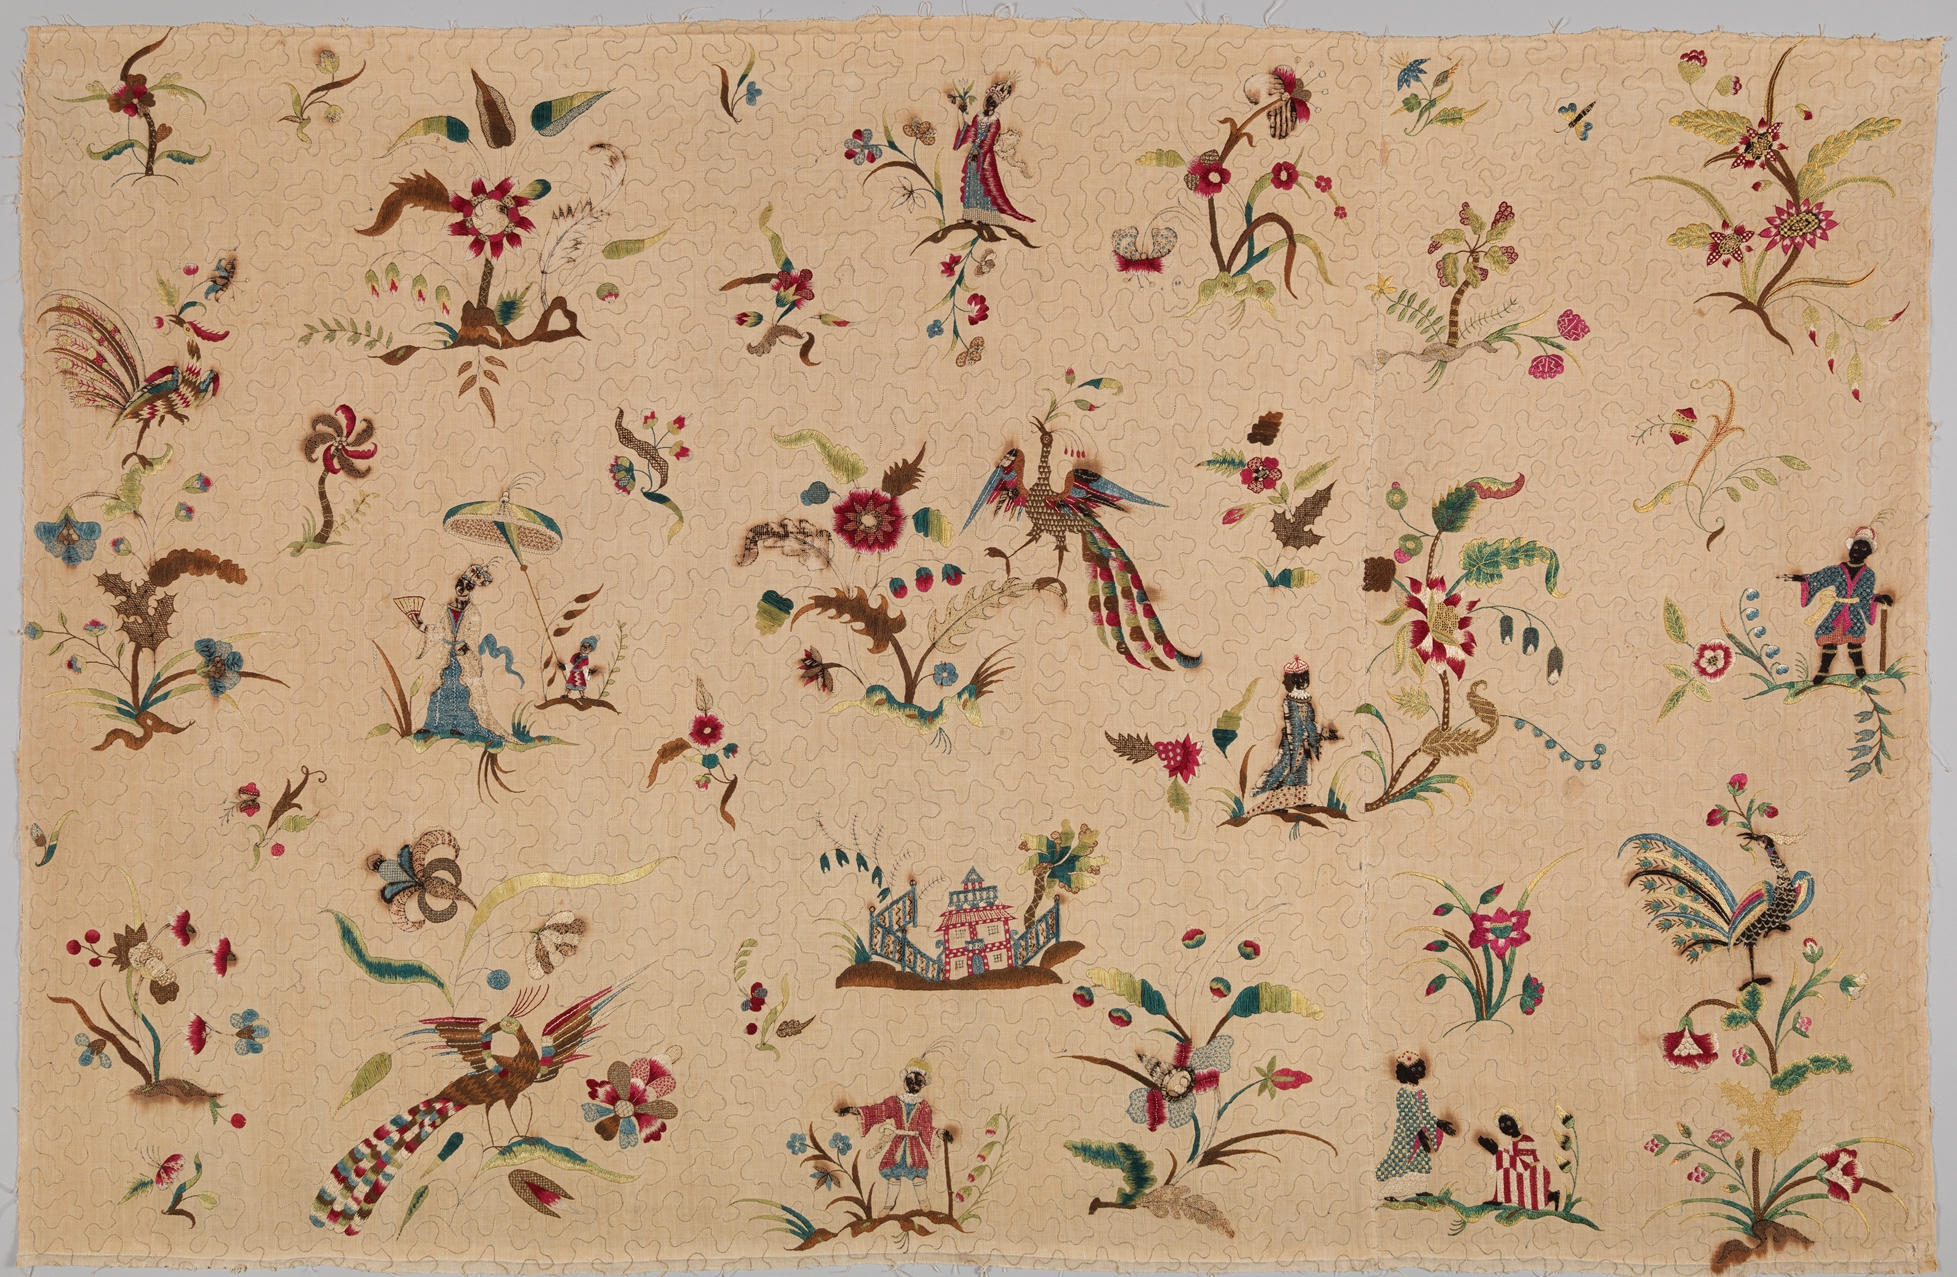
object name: panel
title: Panel for a skirt or petticoat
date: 1690-1710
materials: linen, silk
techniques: embroidery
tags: birds,chinoiserie,men,women,flowers